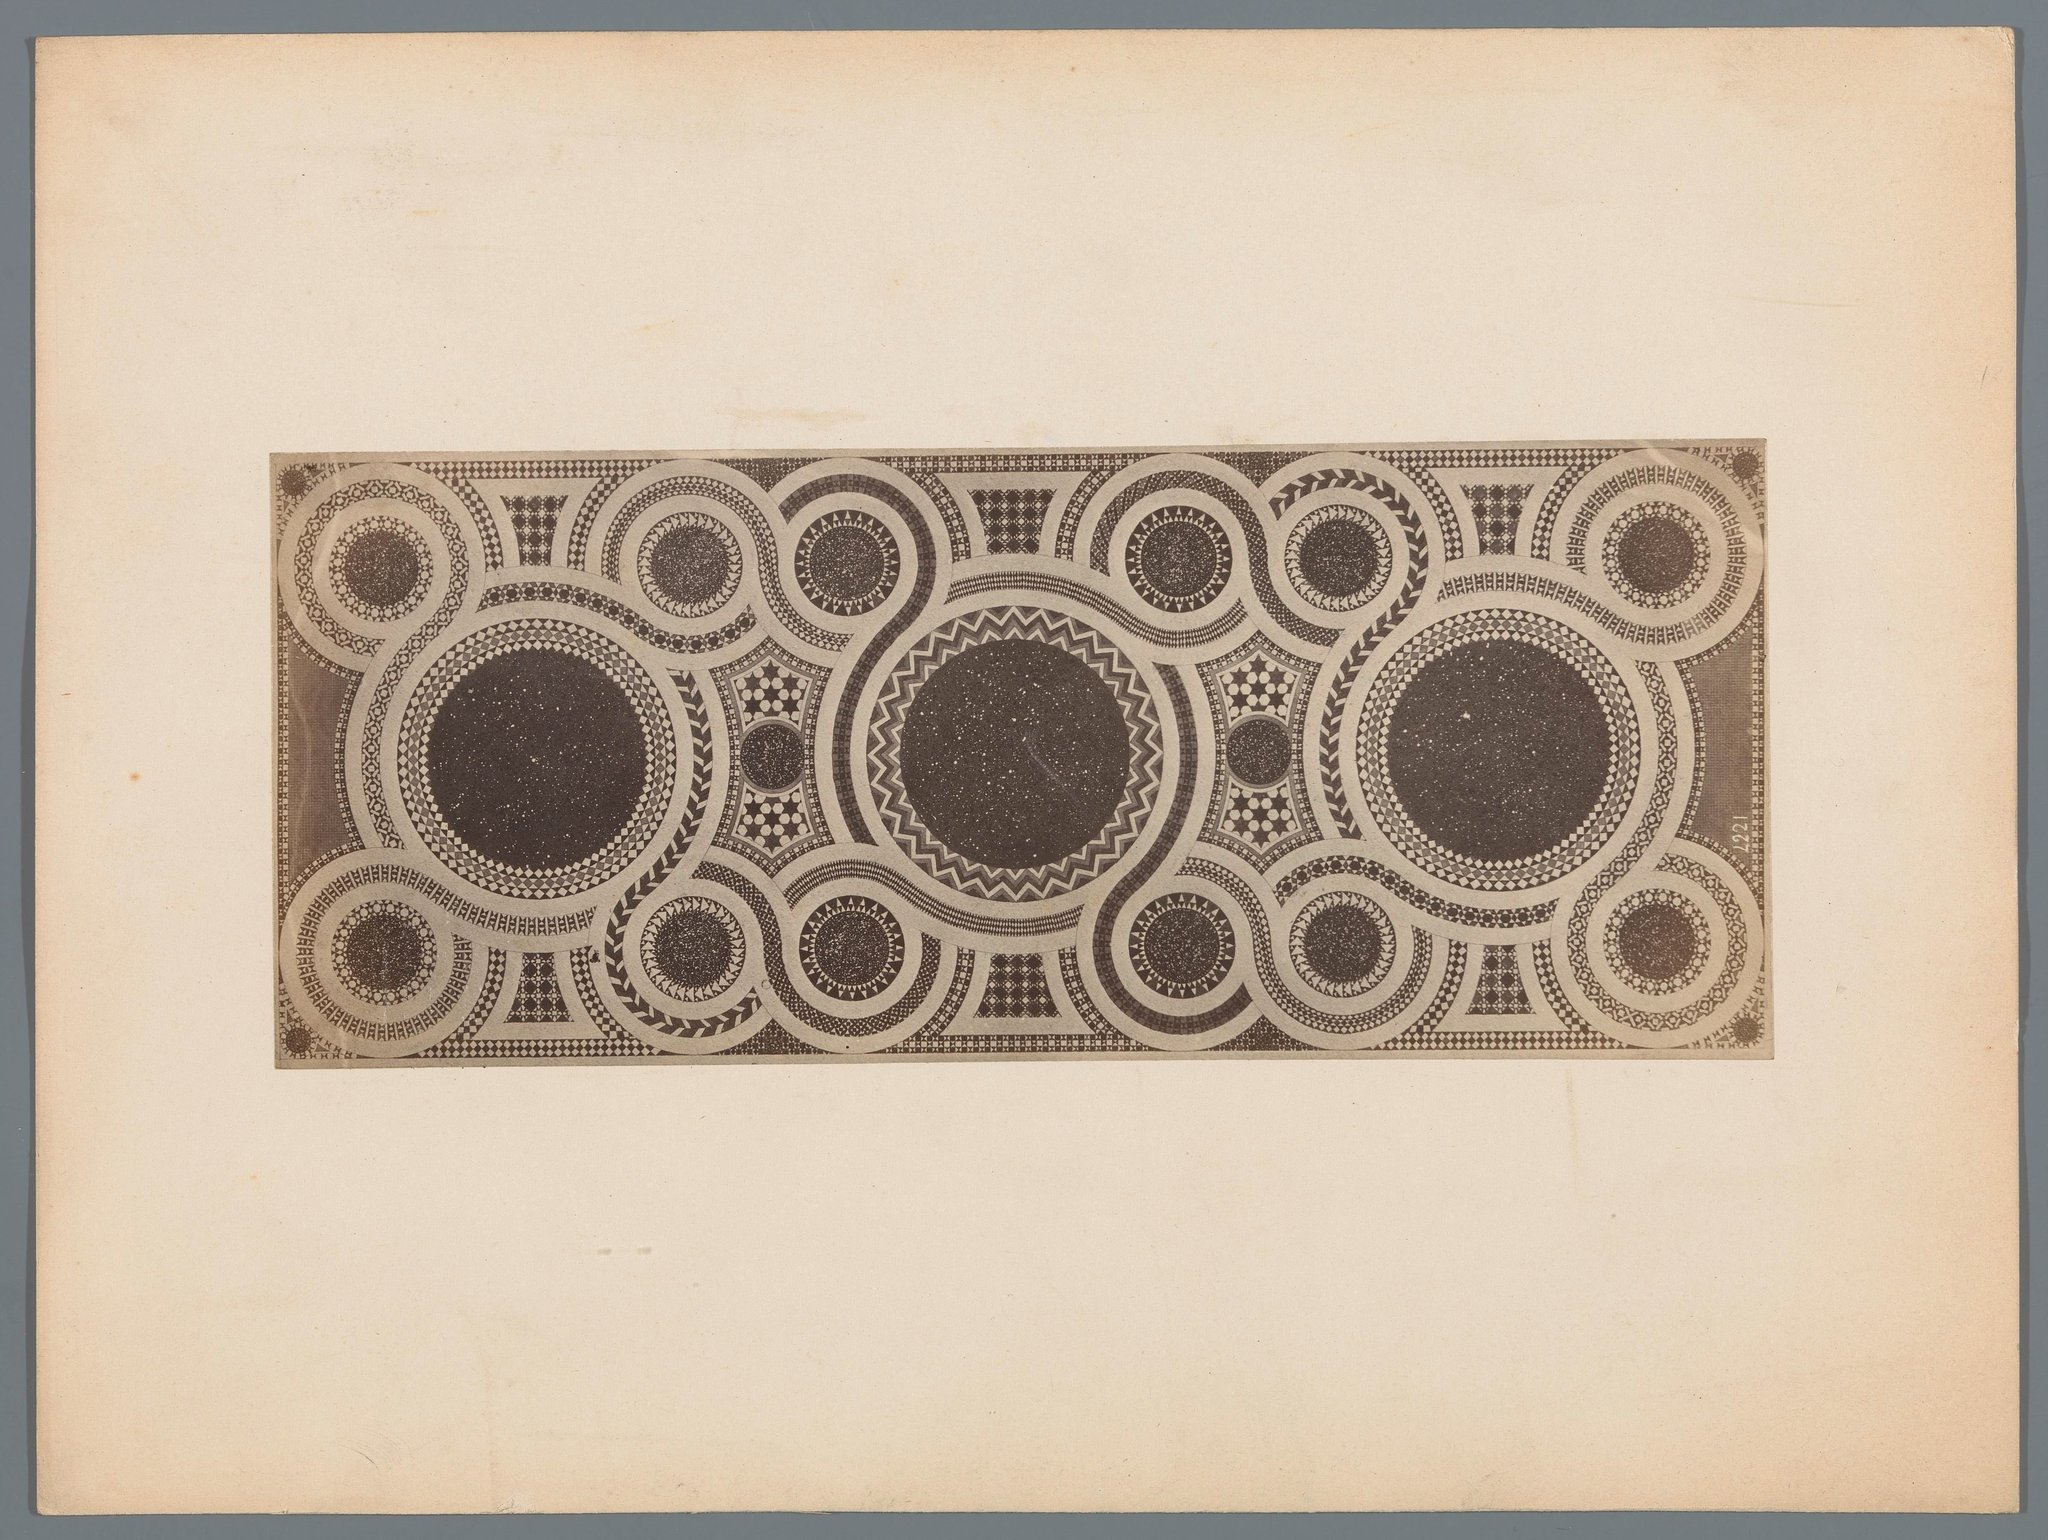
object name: photograph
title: Mozaïek met geometrische patronen, vermoedelijk een vloer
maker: Anonymous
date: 1875-1900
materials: cardboard, photographic support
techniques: albumen print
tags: ornament ~ geometric motifs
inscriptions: collector's mark: Lugt 3937, number: ‘4221’